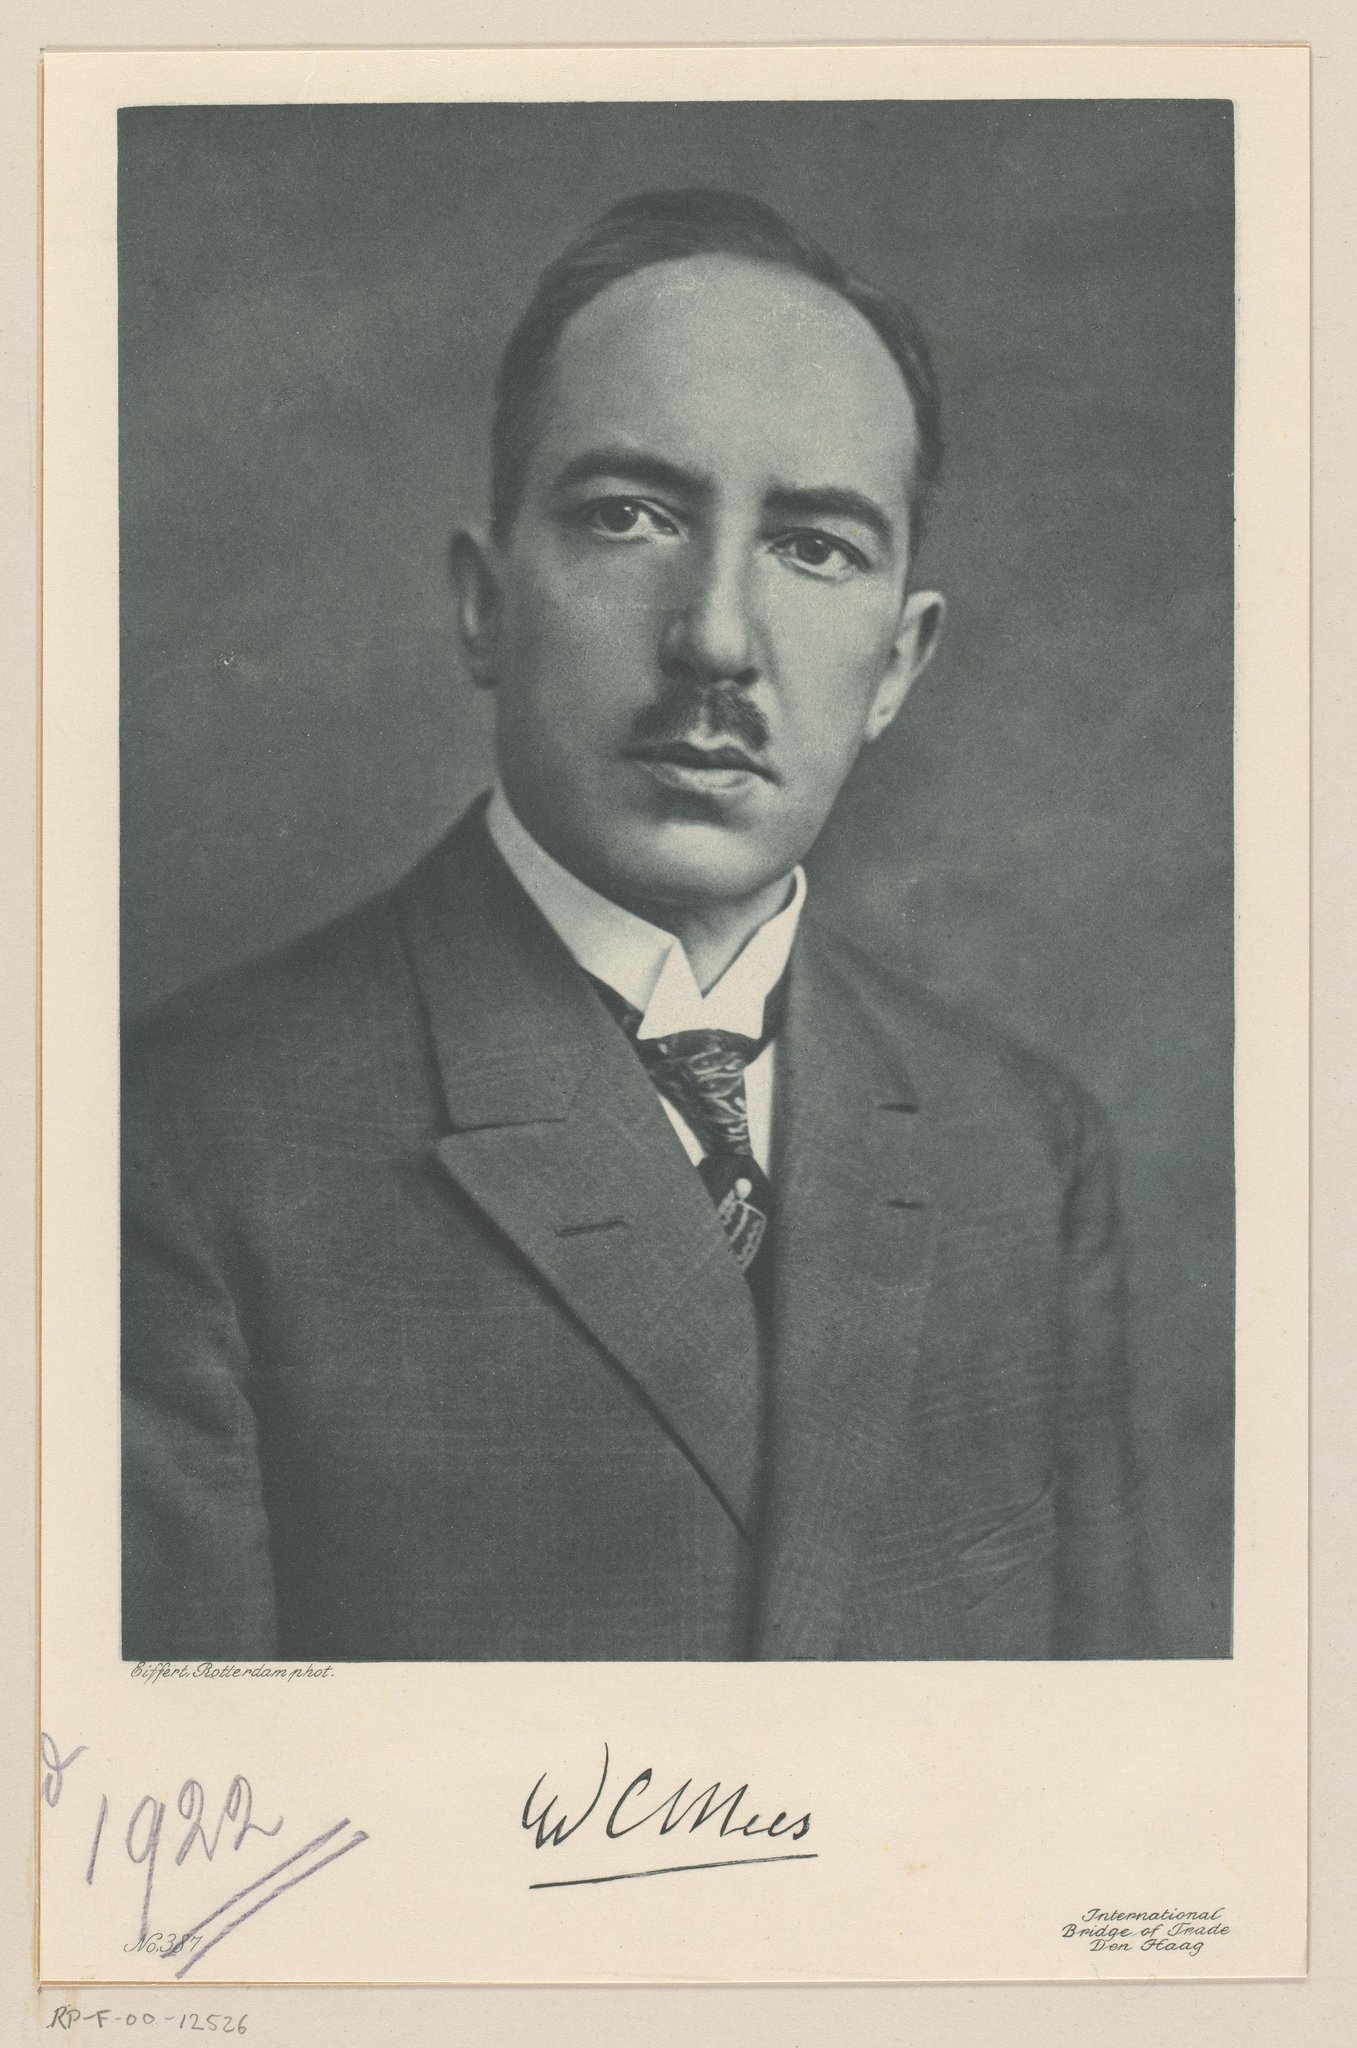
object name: photomechanical print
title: Portret van Willem Cornelis Mees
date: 1922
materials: cardboard, paper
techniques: photoaquatint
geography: amsterdam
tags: rotterdam, historical persons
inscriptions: number: ‘No. 387’, inscription: ‘International/ Bridge of Trade/ Den Haag’